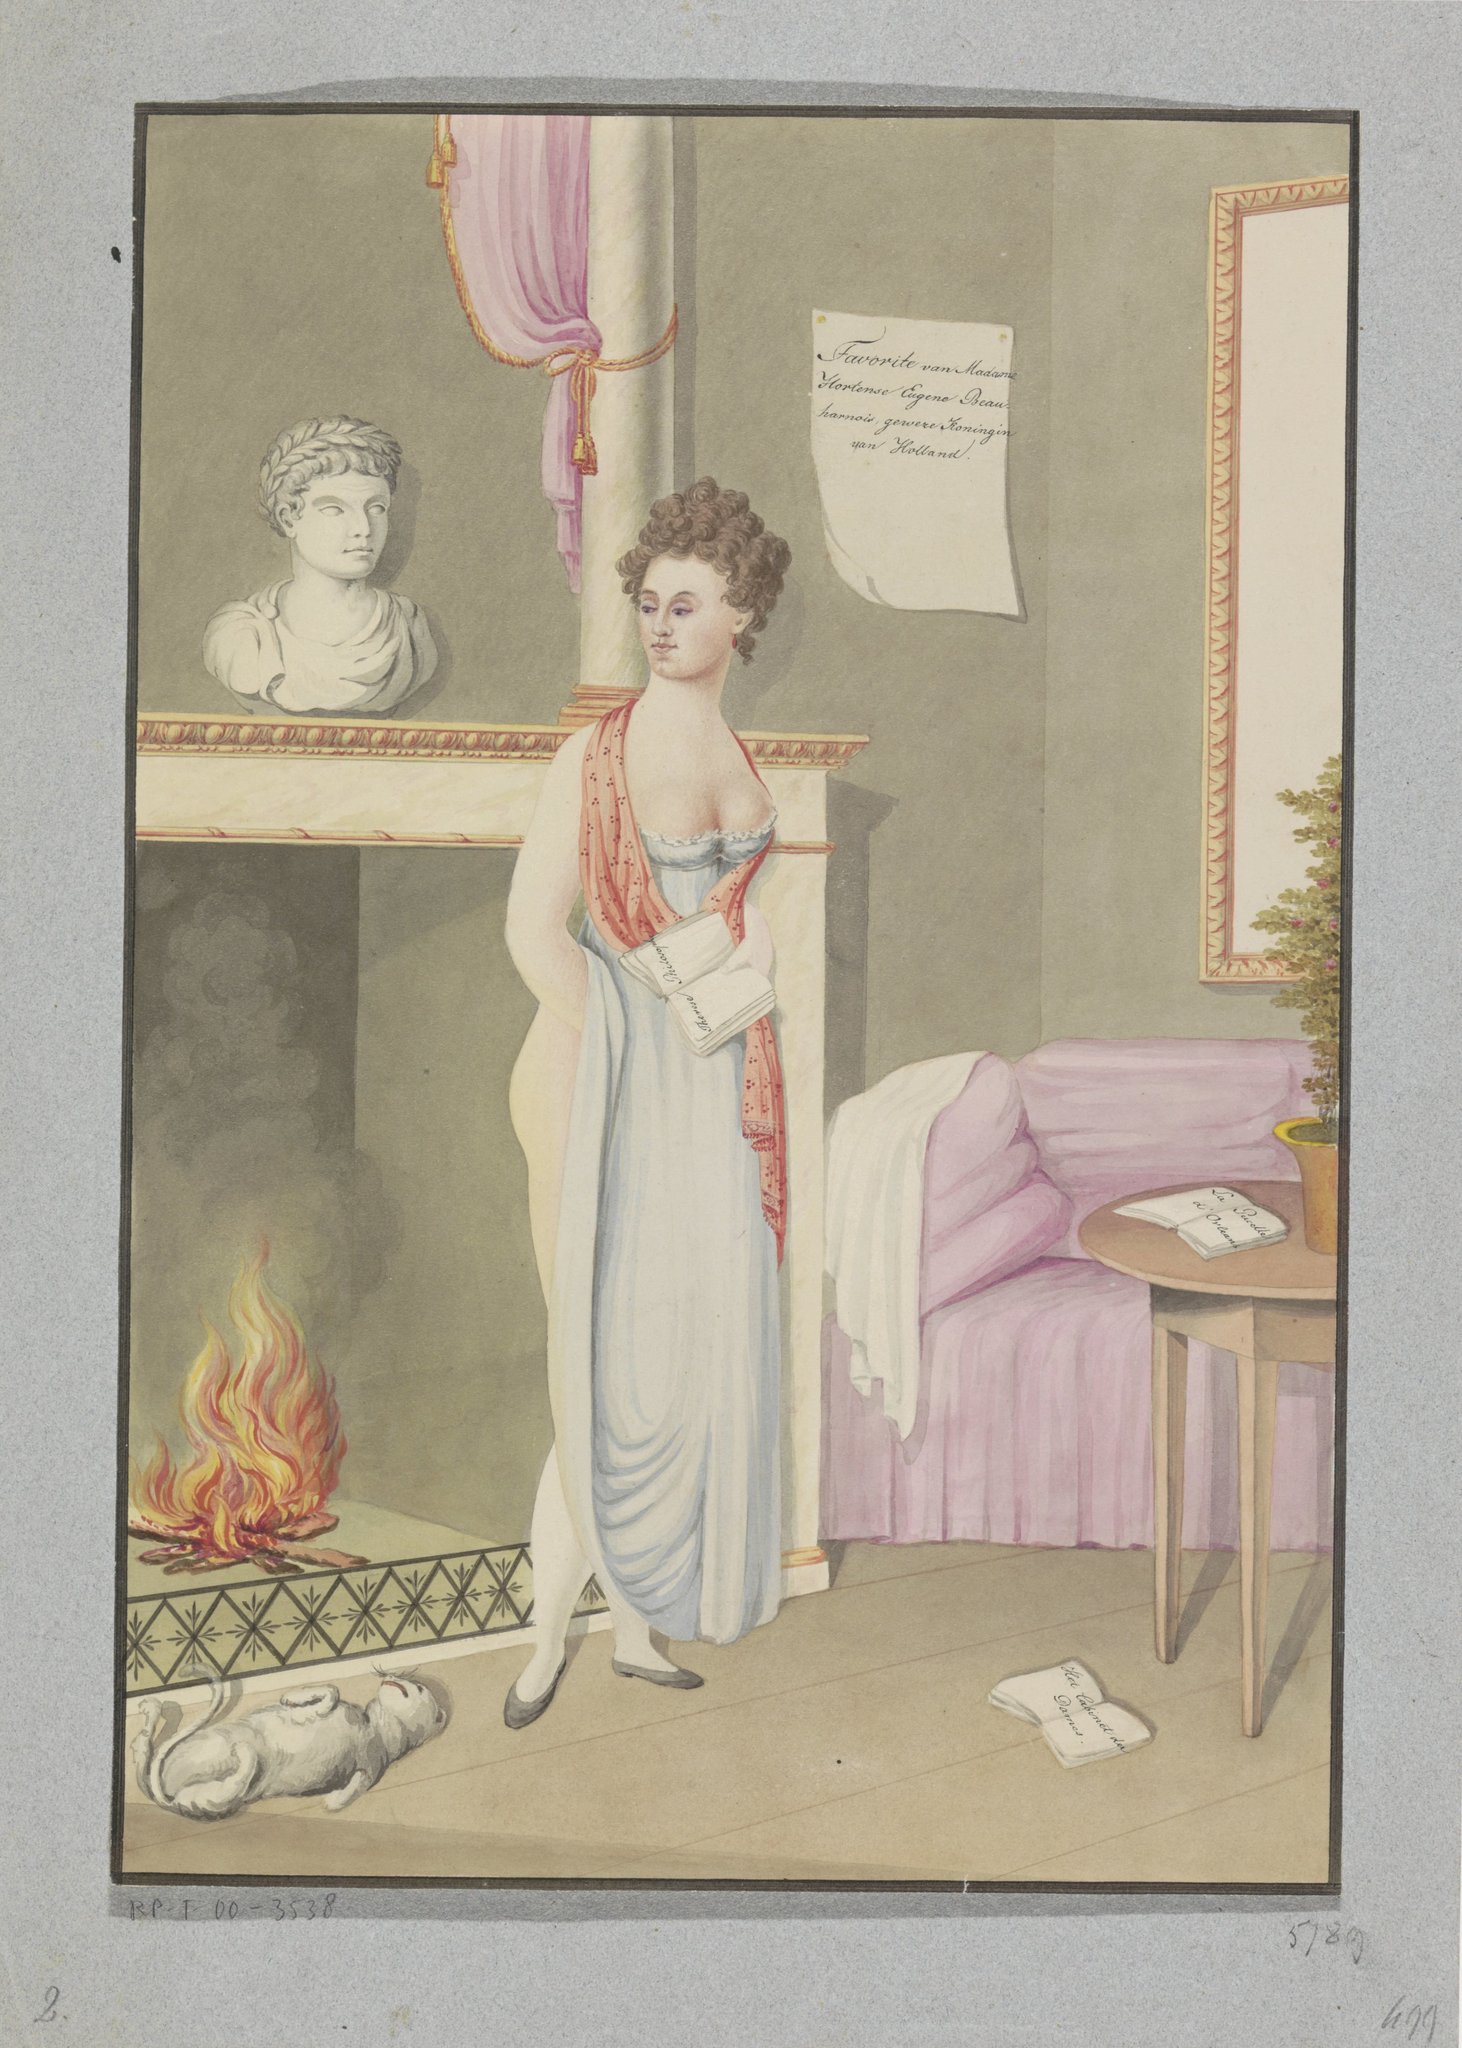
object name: drawing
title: Queen Hortense de Beauharnais in her Private Apartments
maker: Anonymous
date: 1810-1820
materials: paper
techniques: brush, pen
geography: netherlands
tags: paris, scabrous scenes, pornography, masturbation, onanism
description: Closely watched by the bust of her stepfather, Napoleon, Queen Hortense is reading Thérèse philosophe, a pornographic novel, with her hand wandering under her dress and her bottom exposed to the fire. This obscene political caricature mocks the sexual appetite of Louis Bonaparte’s wife, briefly Queen of Holland (1806–1810), who was known for her numerous extramarital affairs.